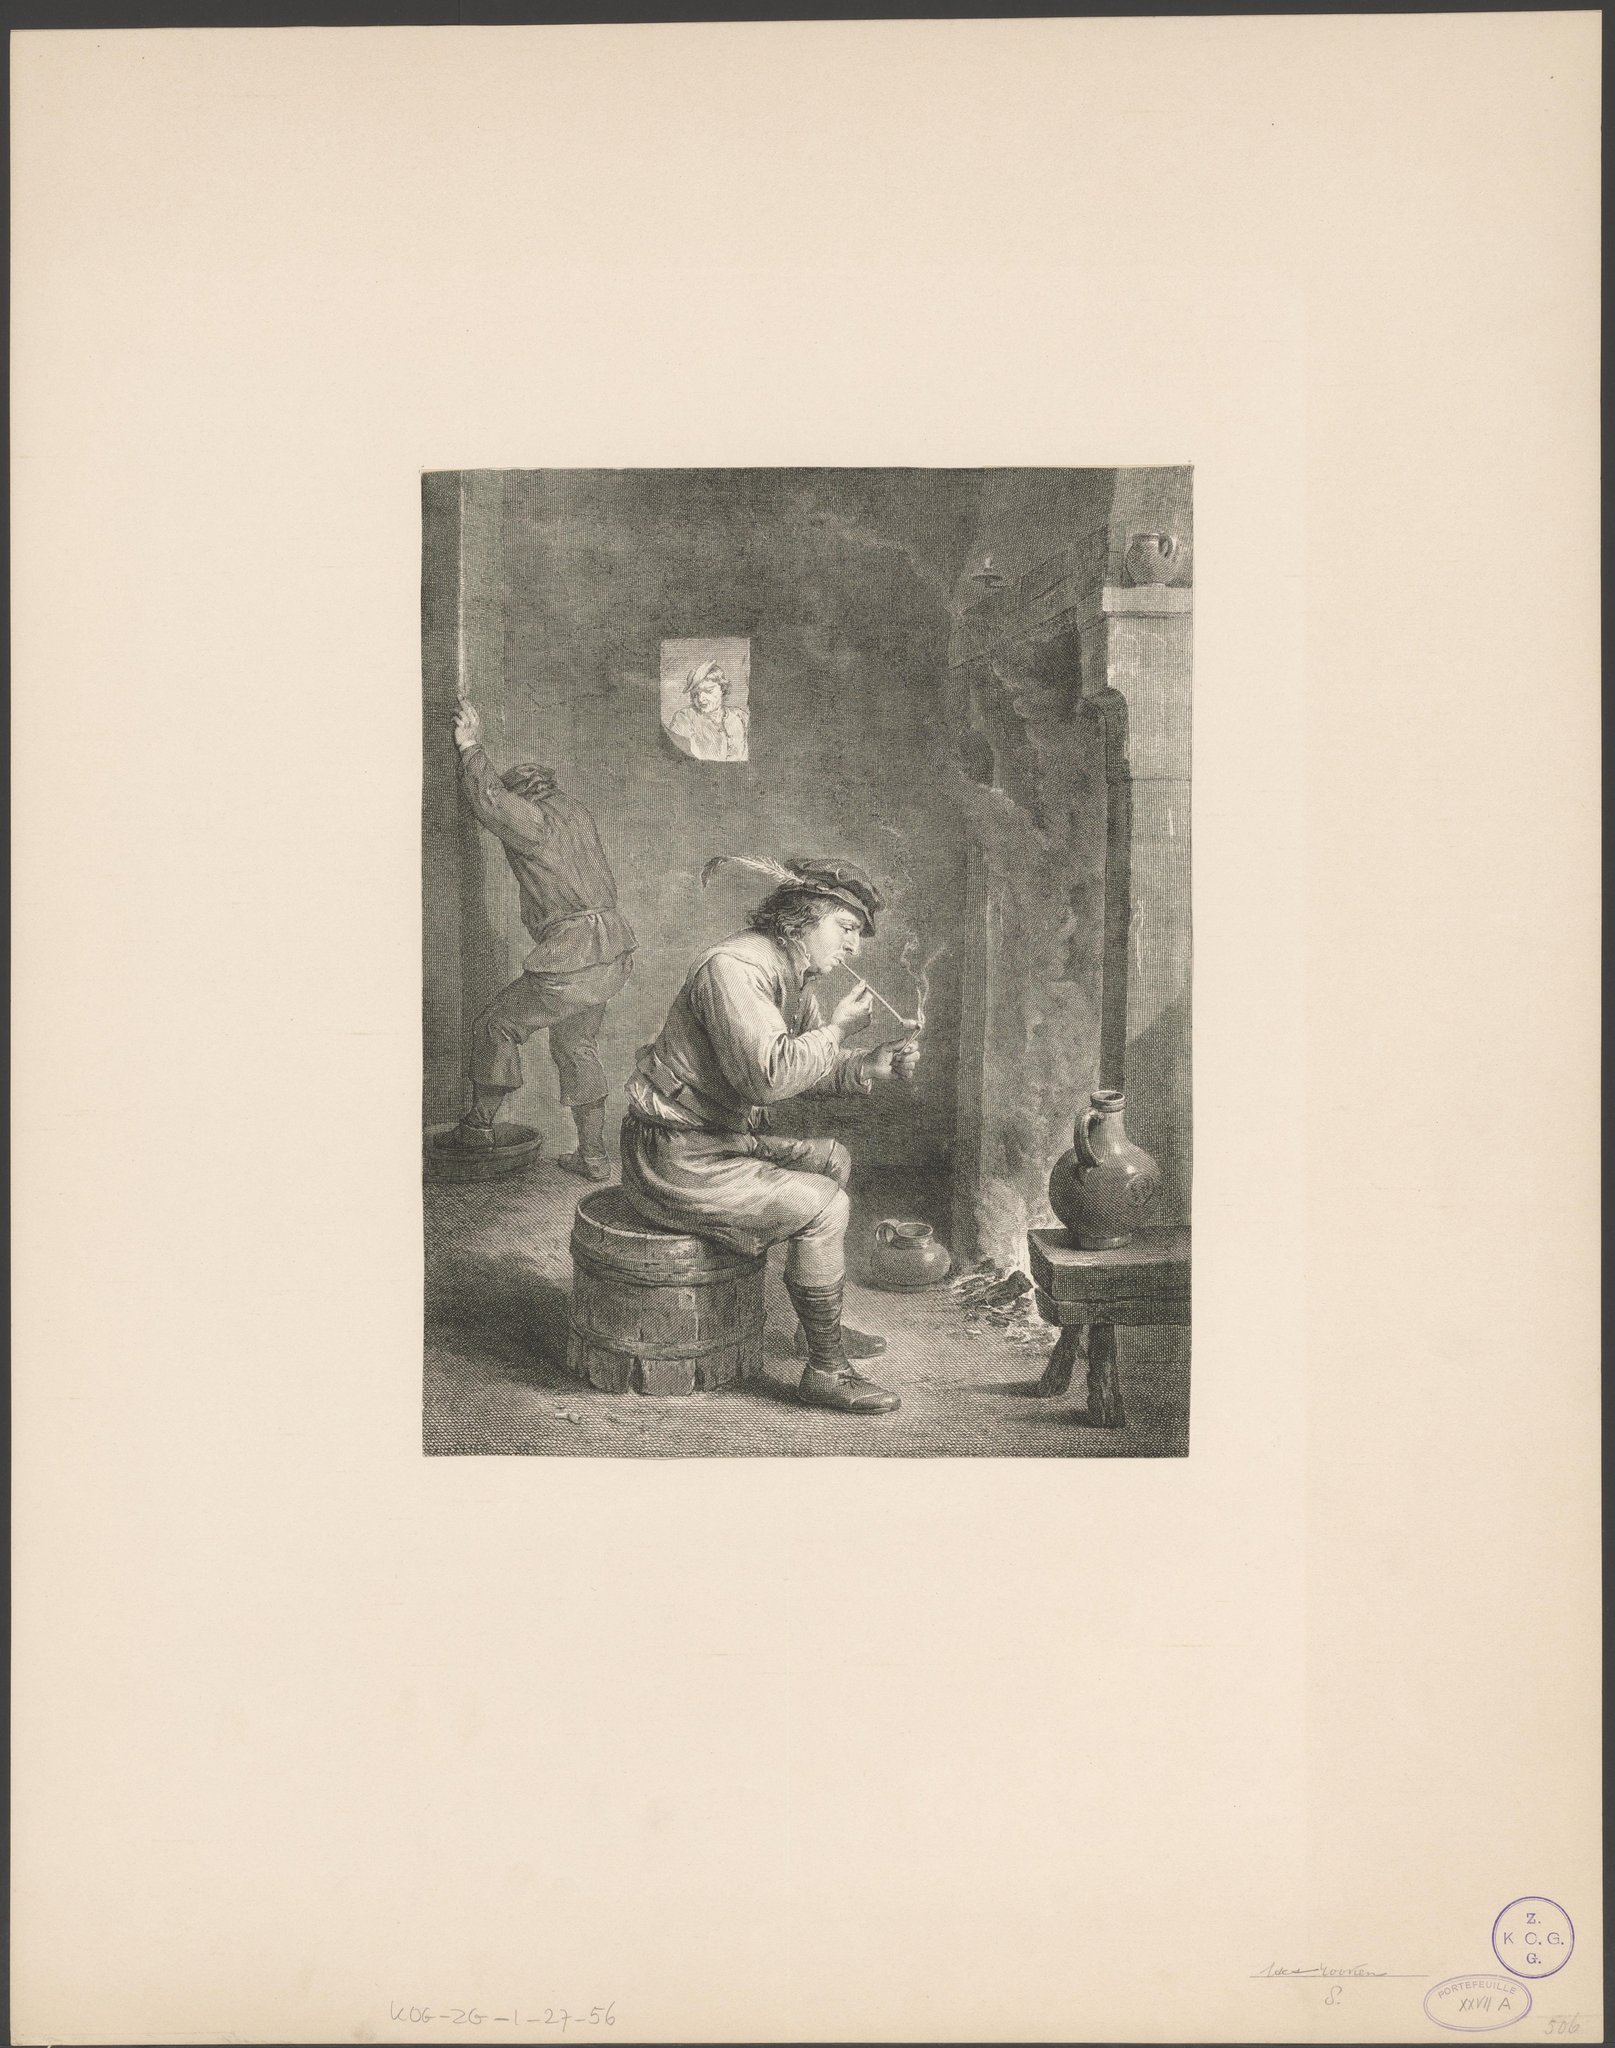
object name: print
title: Rokende man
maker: Anonymous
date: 1650-1750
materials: paper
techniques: etching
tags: inn, coffee-house, public house, etc., pipe ~ tobacco, open hearth, fire-place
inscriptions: collector's mark: Lugt 1641, collector's mark